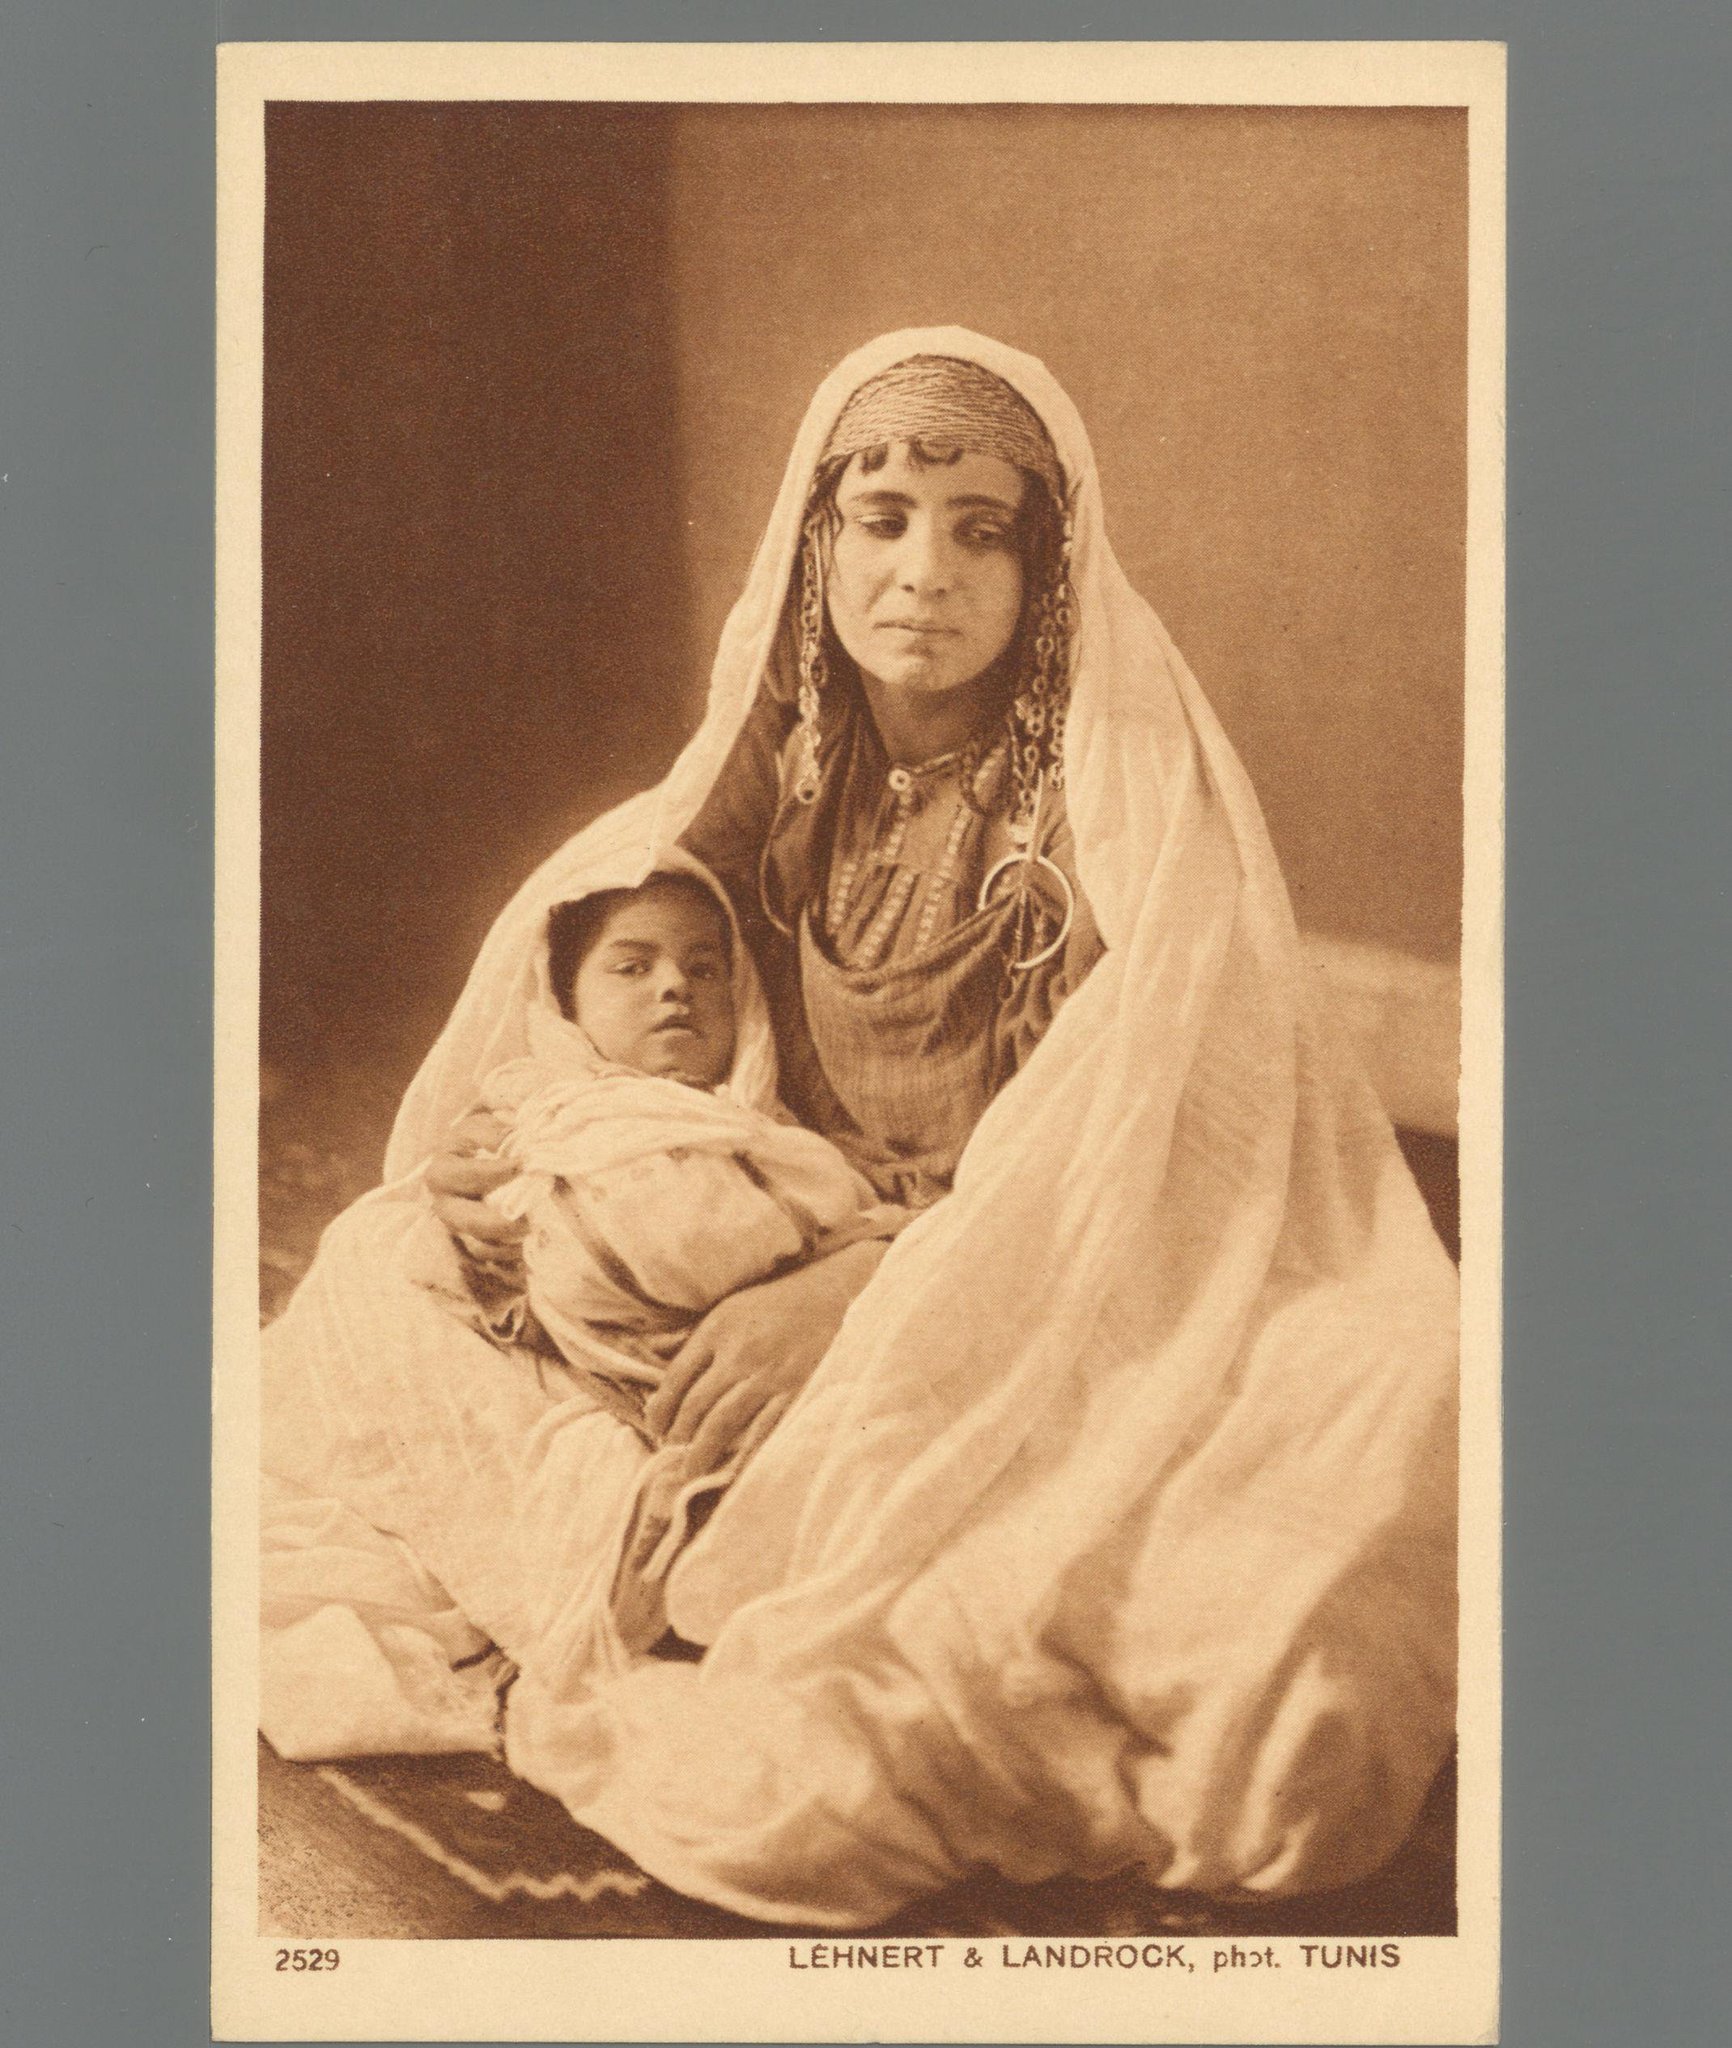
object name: photomechanical print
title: Types d'orient. Serie III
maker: Anonymous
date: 1903-1930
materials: cardboard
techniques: rotogravure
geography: tunisia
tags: head-gear, historical persons (portraits and scenes from the life) - bb - woman, ornaments, jewels